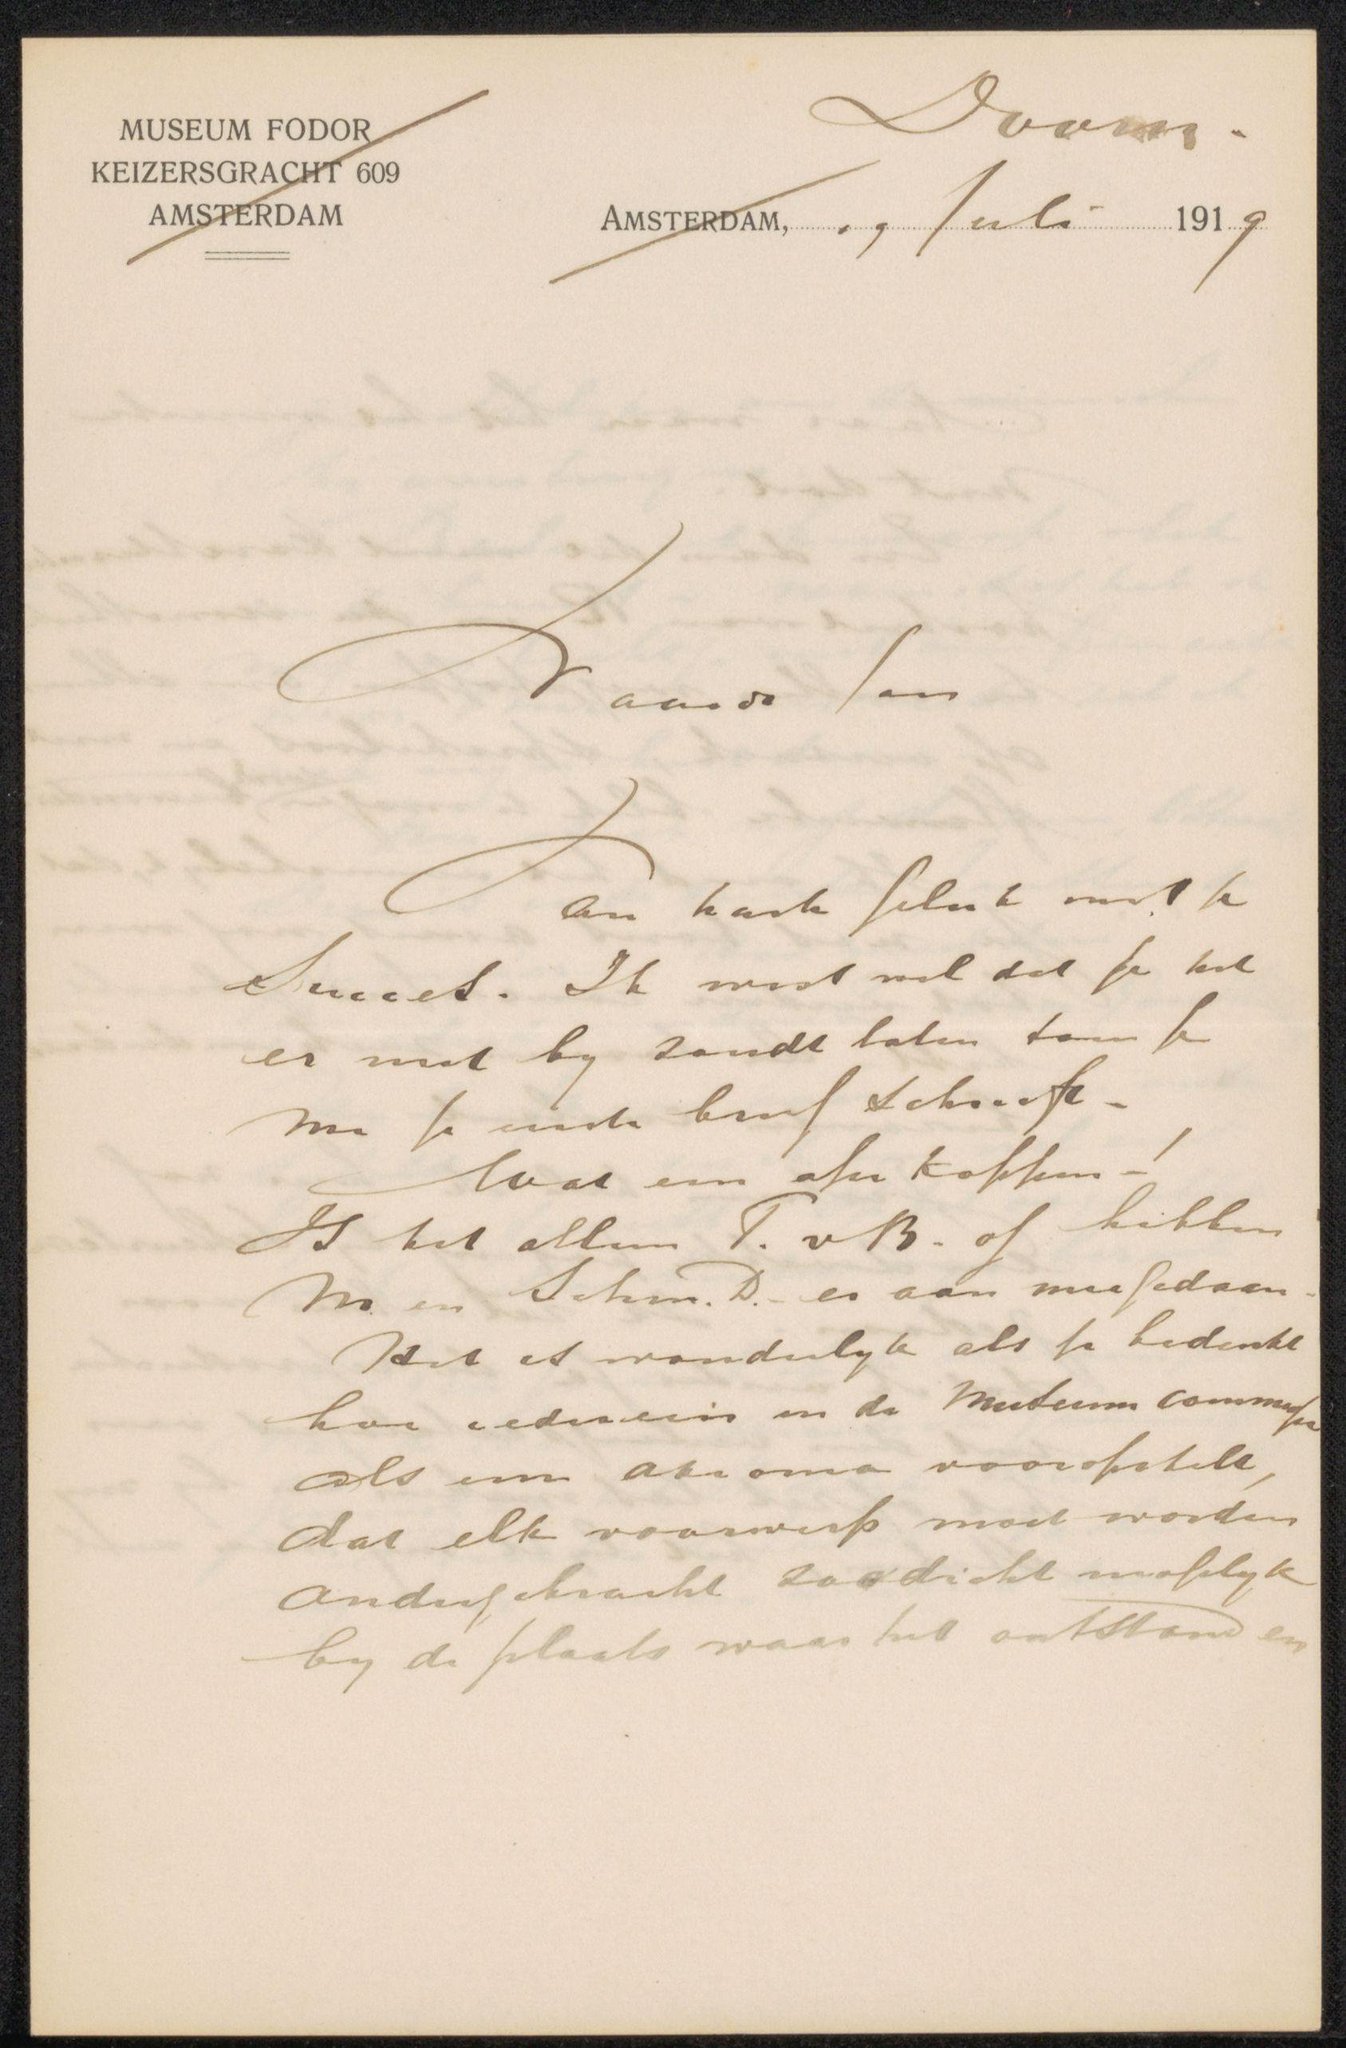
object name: letter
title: Brief aan Jan Veth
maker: cornelis gerardus t hooft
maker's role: draughtsman, painter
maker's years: 1866-1936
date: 1919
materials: ink, paper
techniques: pen, printing, writing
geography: doorn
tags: print maker, designer, jan veth, rotterdam, frederik schmidt-degener, haarlem, jonkheer hendrik teding van berkhout (1879-1969), buren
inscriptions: collector's mark: ‘RPK’